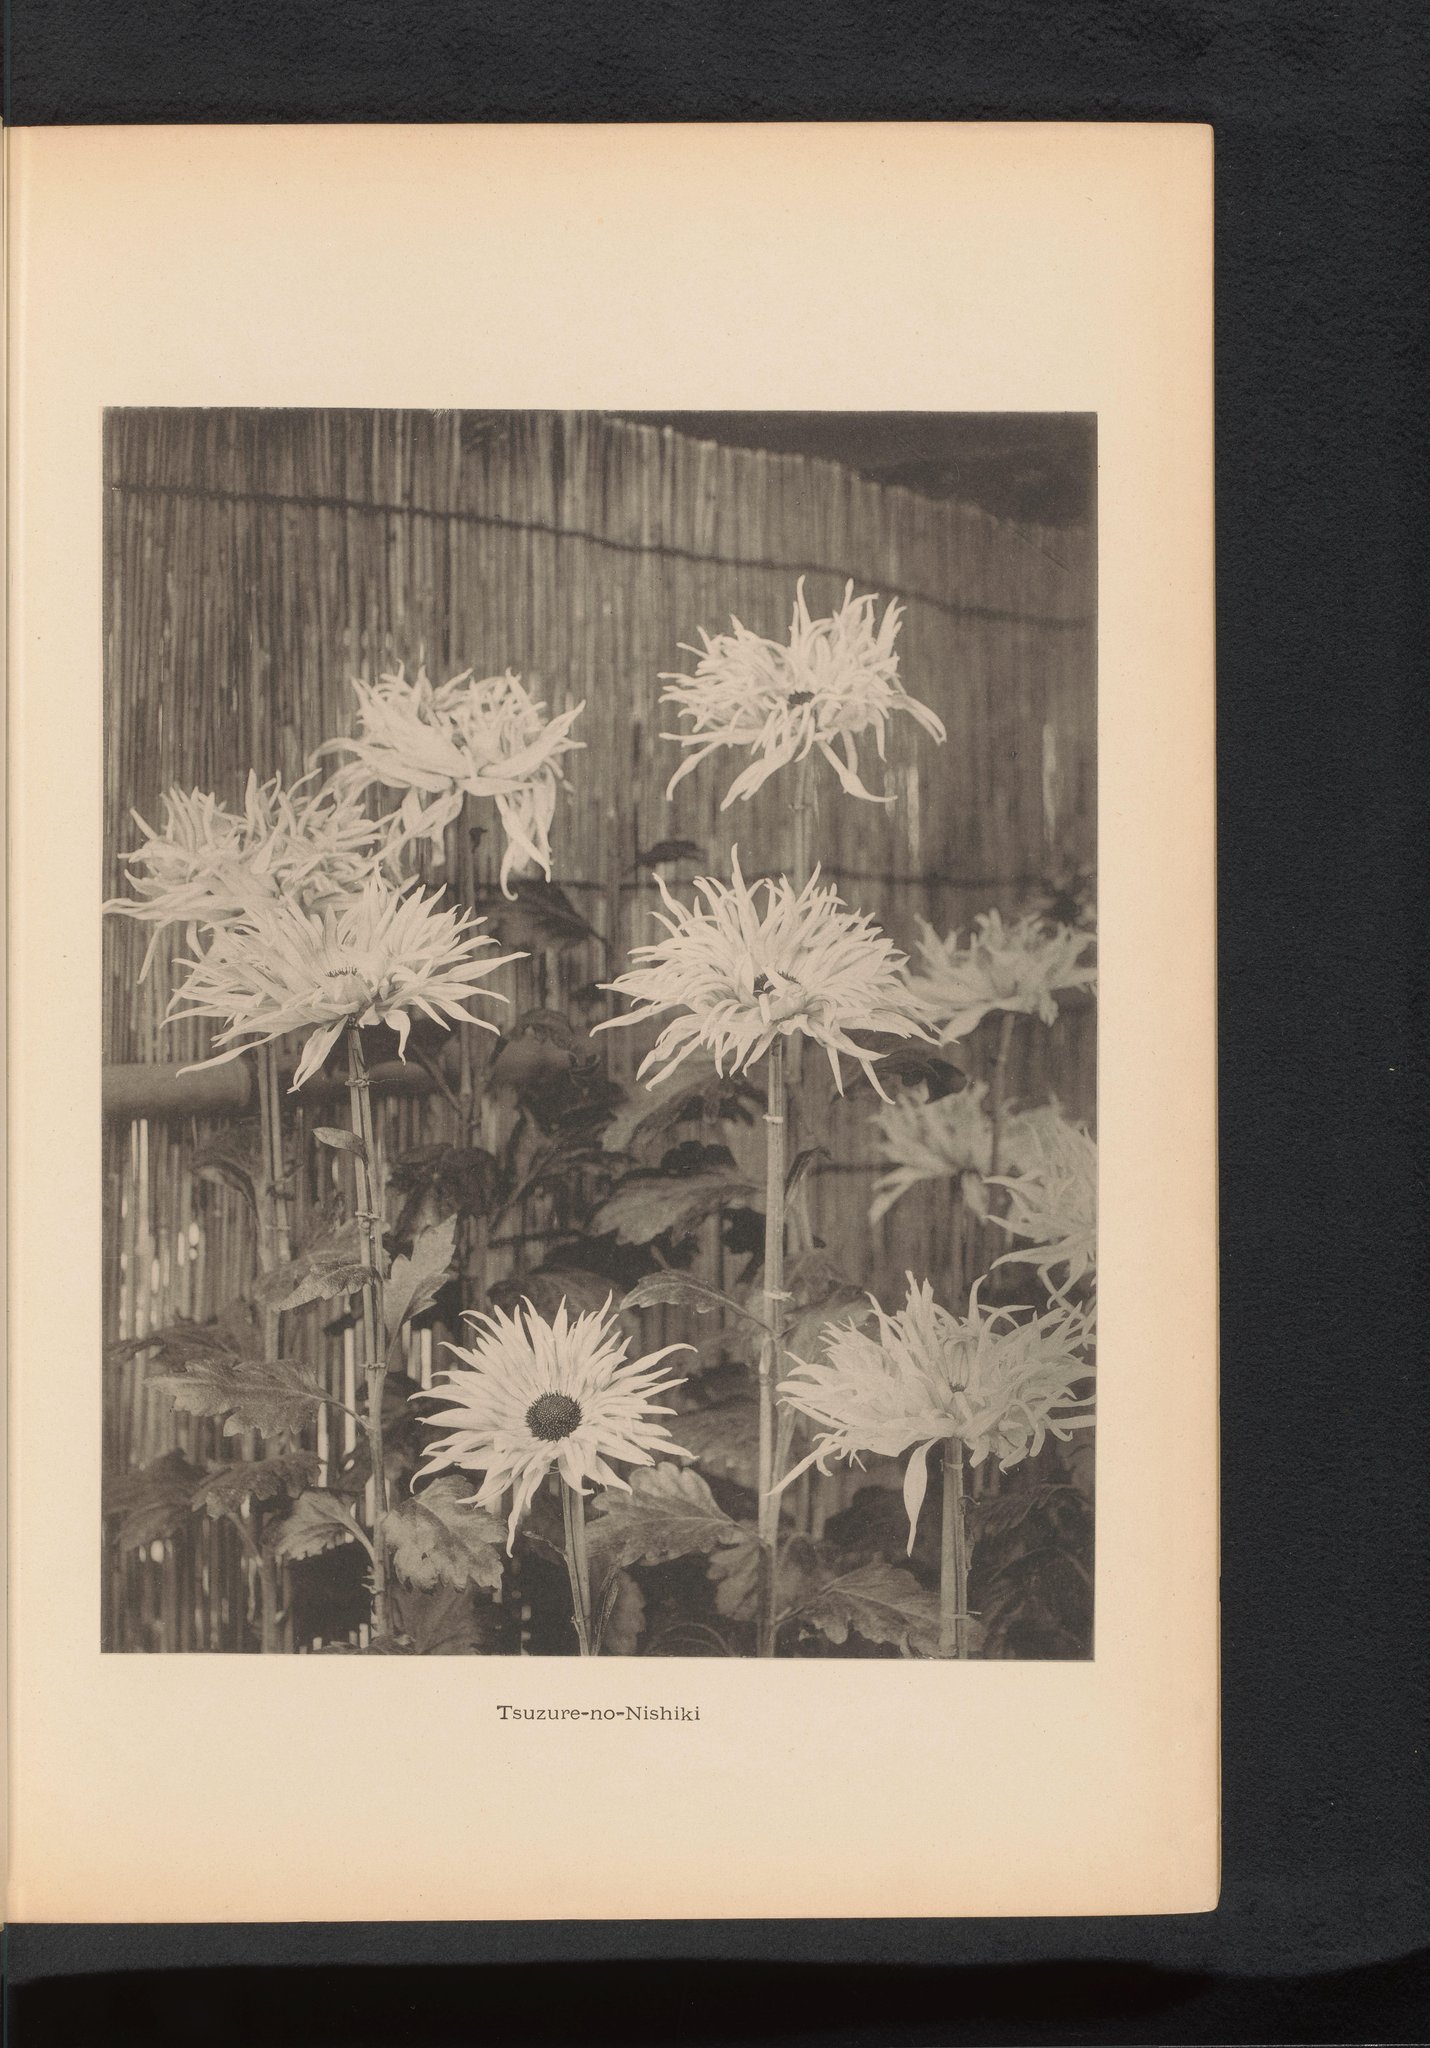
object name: photomechanical print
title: Tsuzure-no-Nishiki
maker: kazumasa ogawa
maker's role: auteur, fotograaf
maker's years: 1860-1929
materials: paper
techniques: photograph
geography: tokyo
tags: flowers: chrysanthemum, garden, japan